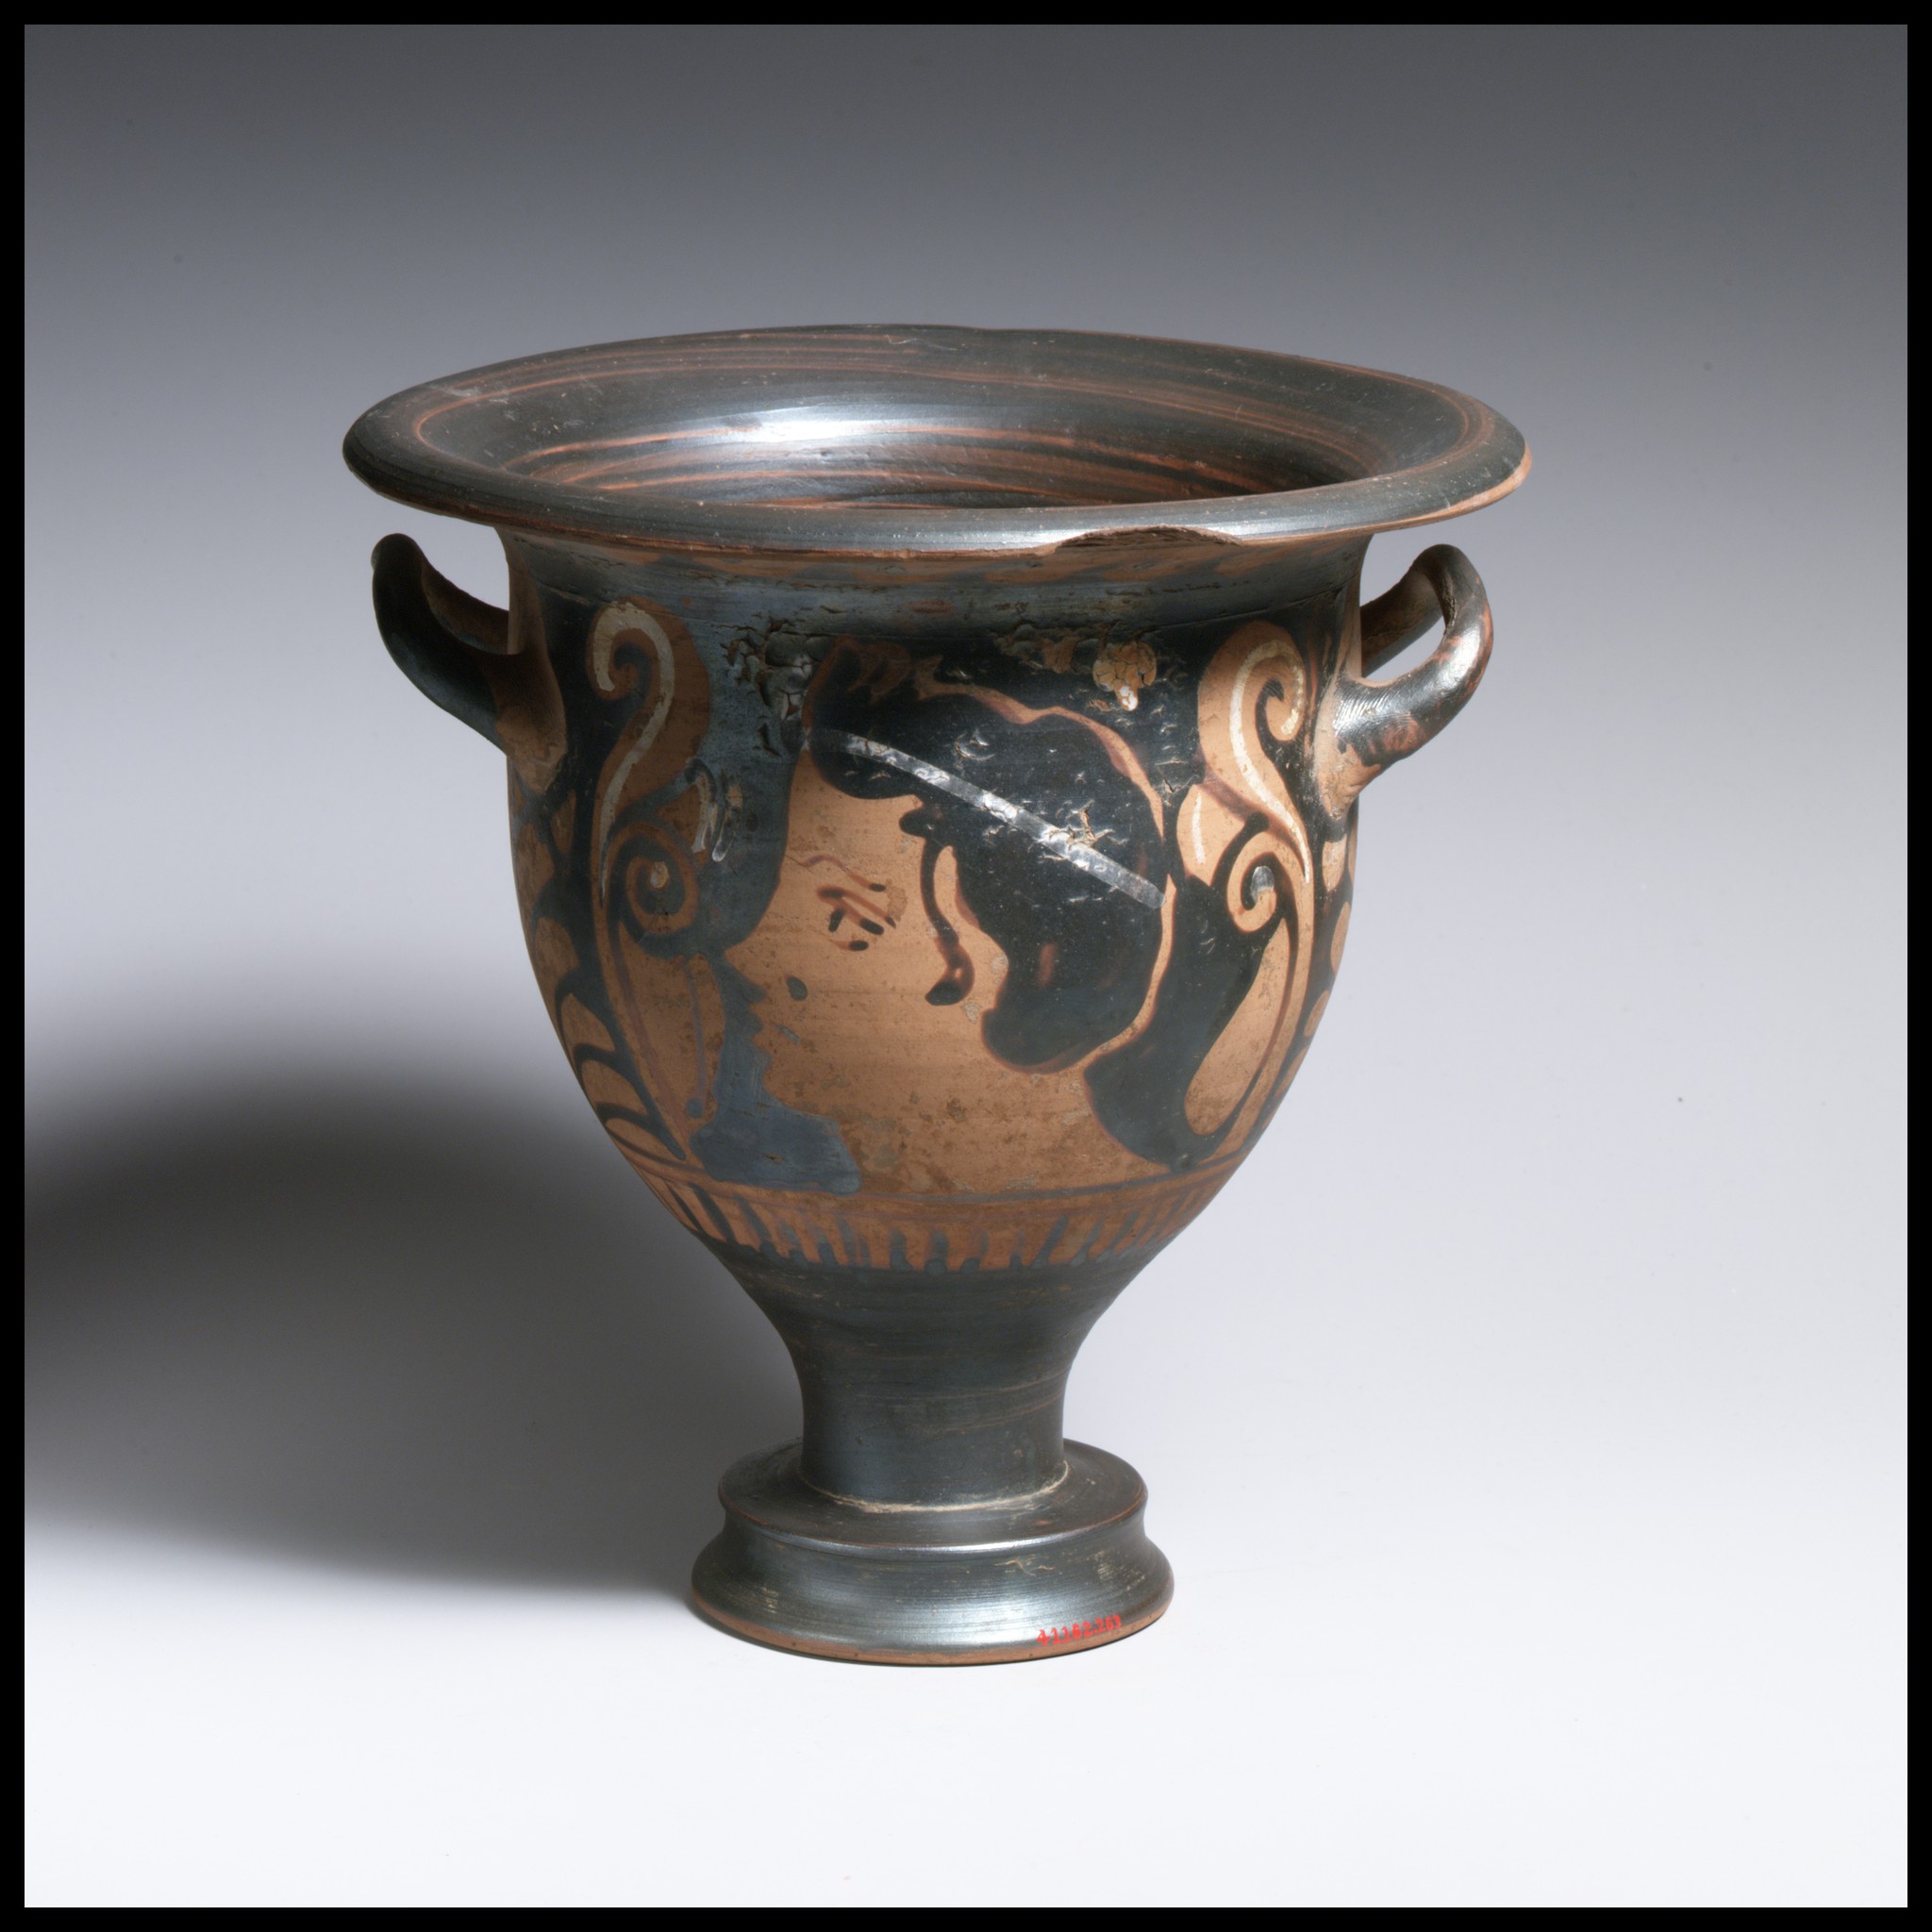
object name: bell krater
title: Bell-krater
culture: greek or south italian or campanian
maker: painter of oxford 1945.73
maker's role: artist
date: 360-330 BCE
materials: terracotta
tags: women